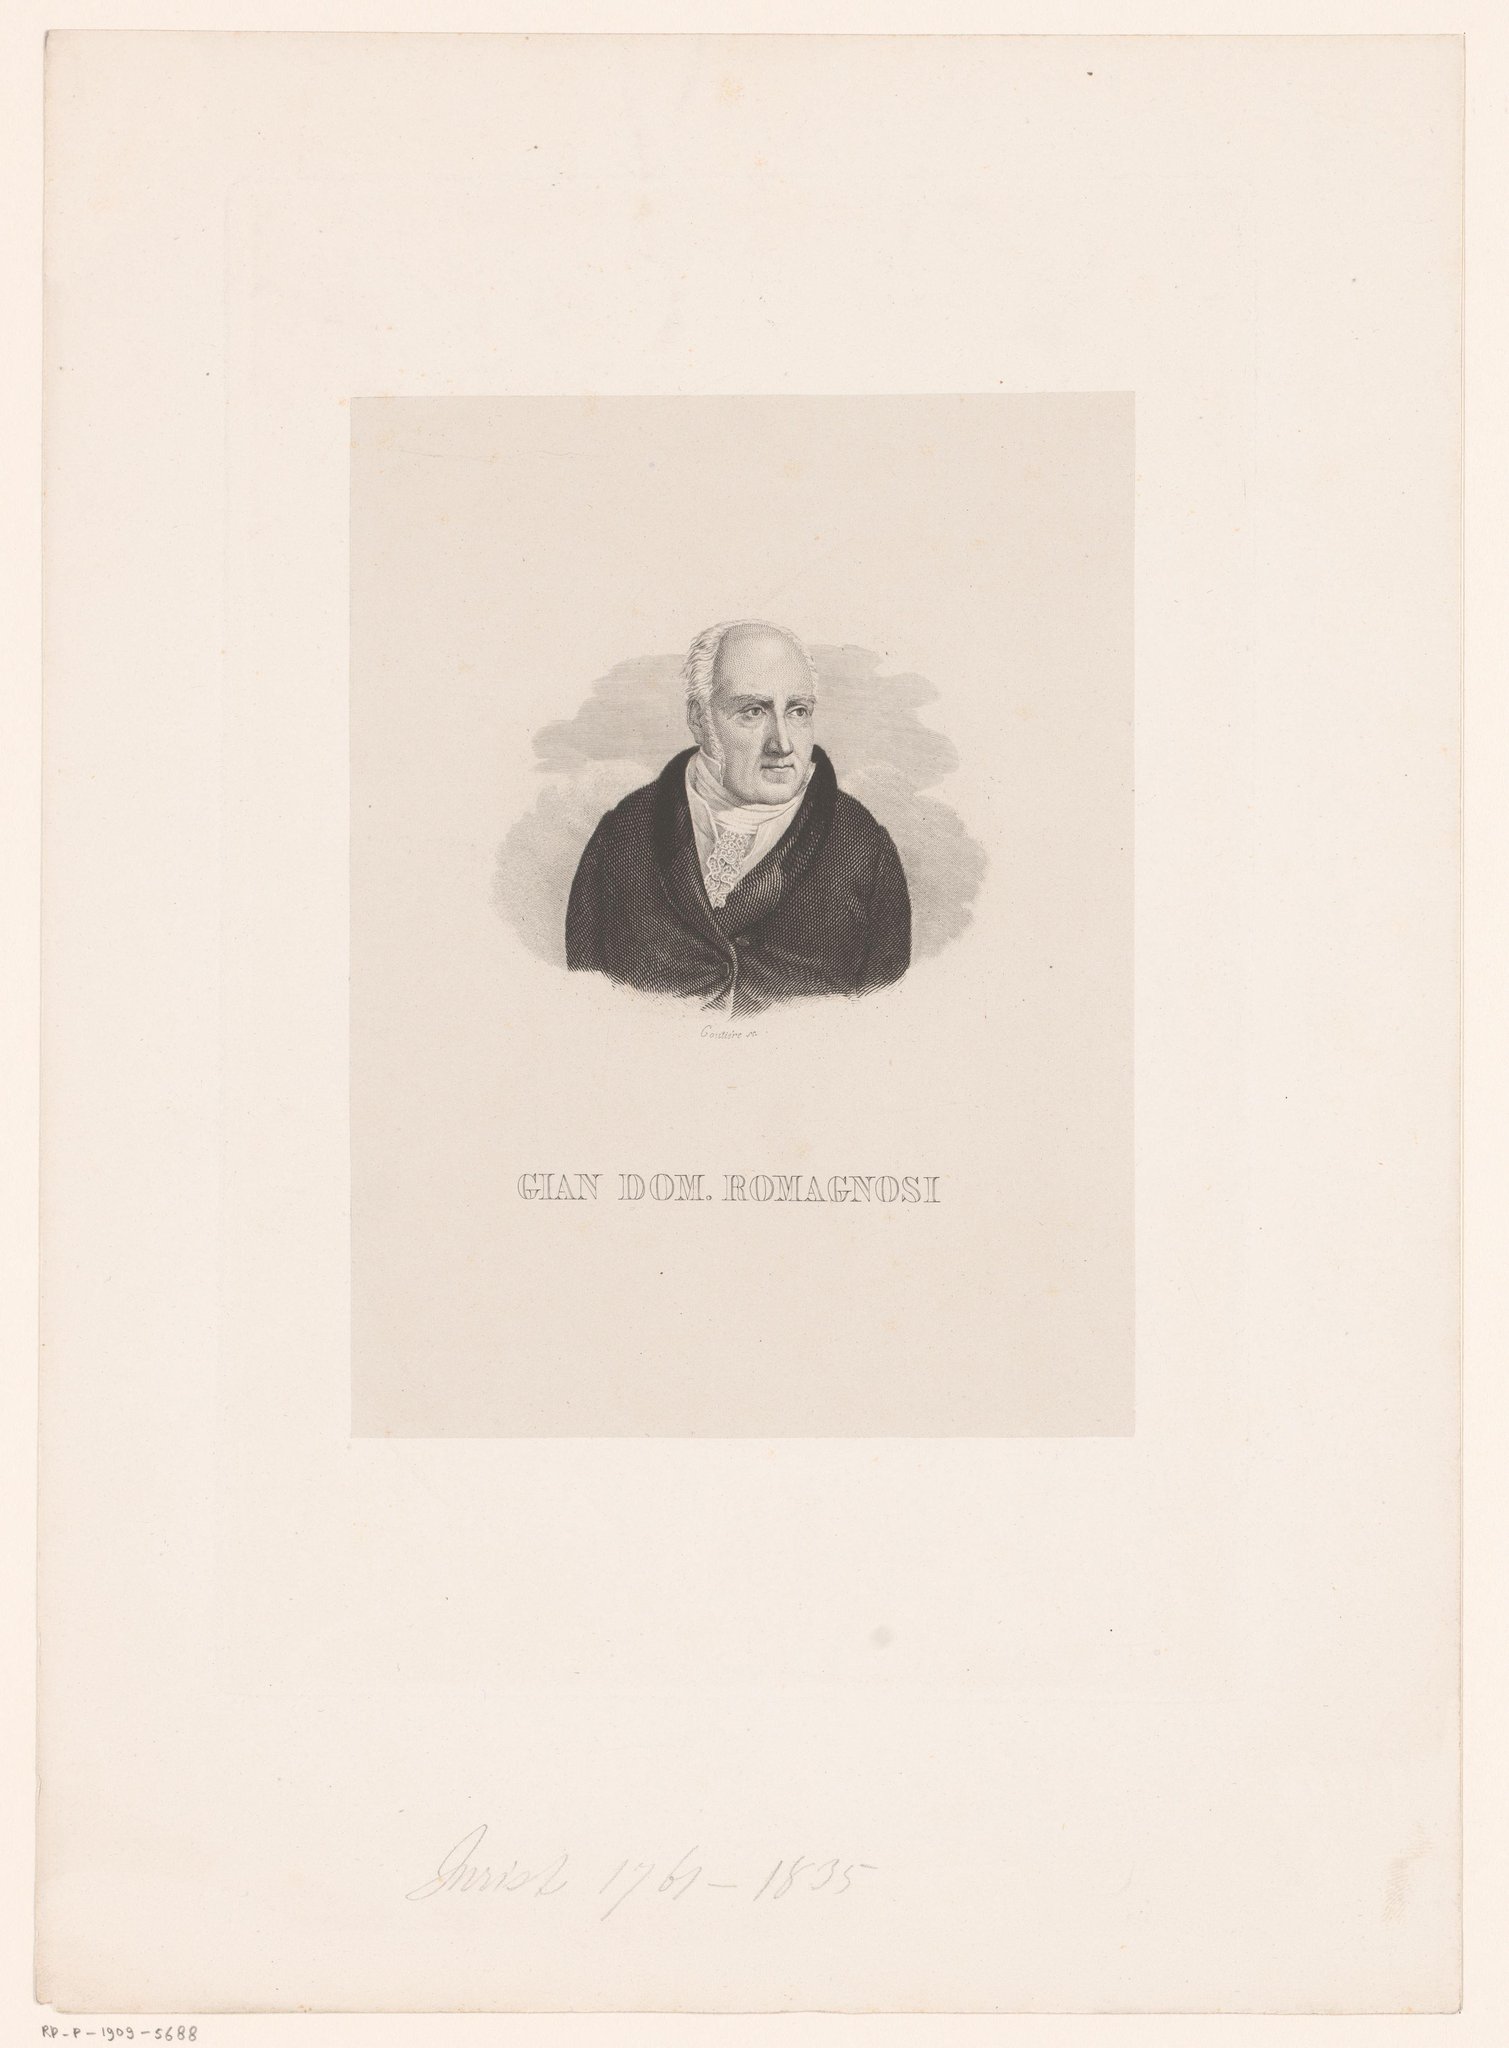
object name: print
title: Portret van Gian Domenico Romagnosi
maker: tony goutière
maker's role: print maker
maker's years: 1808-1890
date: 1818-1890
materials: paper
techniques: engraving, etching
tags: scholar, philosopher, historical persons, lawyer, attorney at law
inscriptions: collector's mark: Lugt 2228